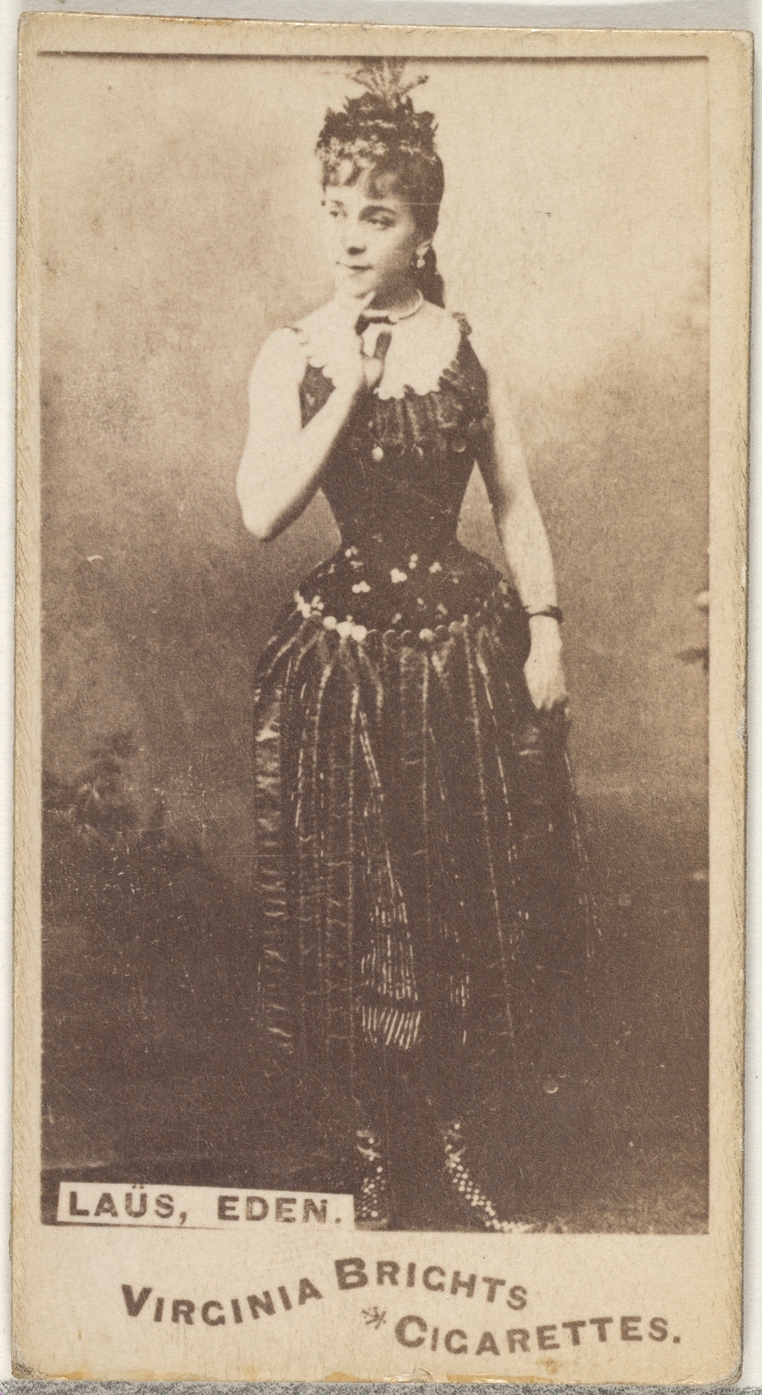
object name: photograph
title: Laus, Eden, from the Actors and Actresses series (N45, Type 1) for Virginia Brights Cigarettes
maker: allen & ginter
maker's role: publisher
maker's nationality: american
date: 1888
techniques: albumen silver print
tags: portraits,women,actresses